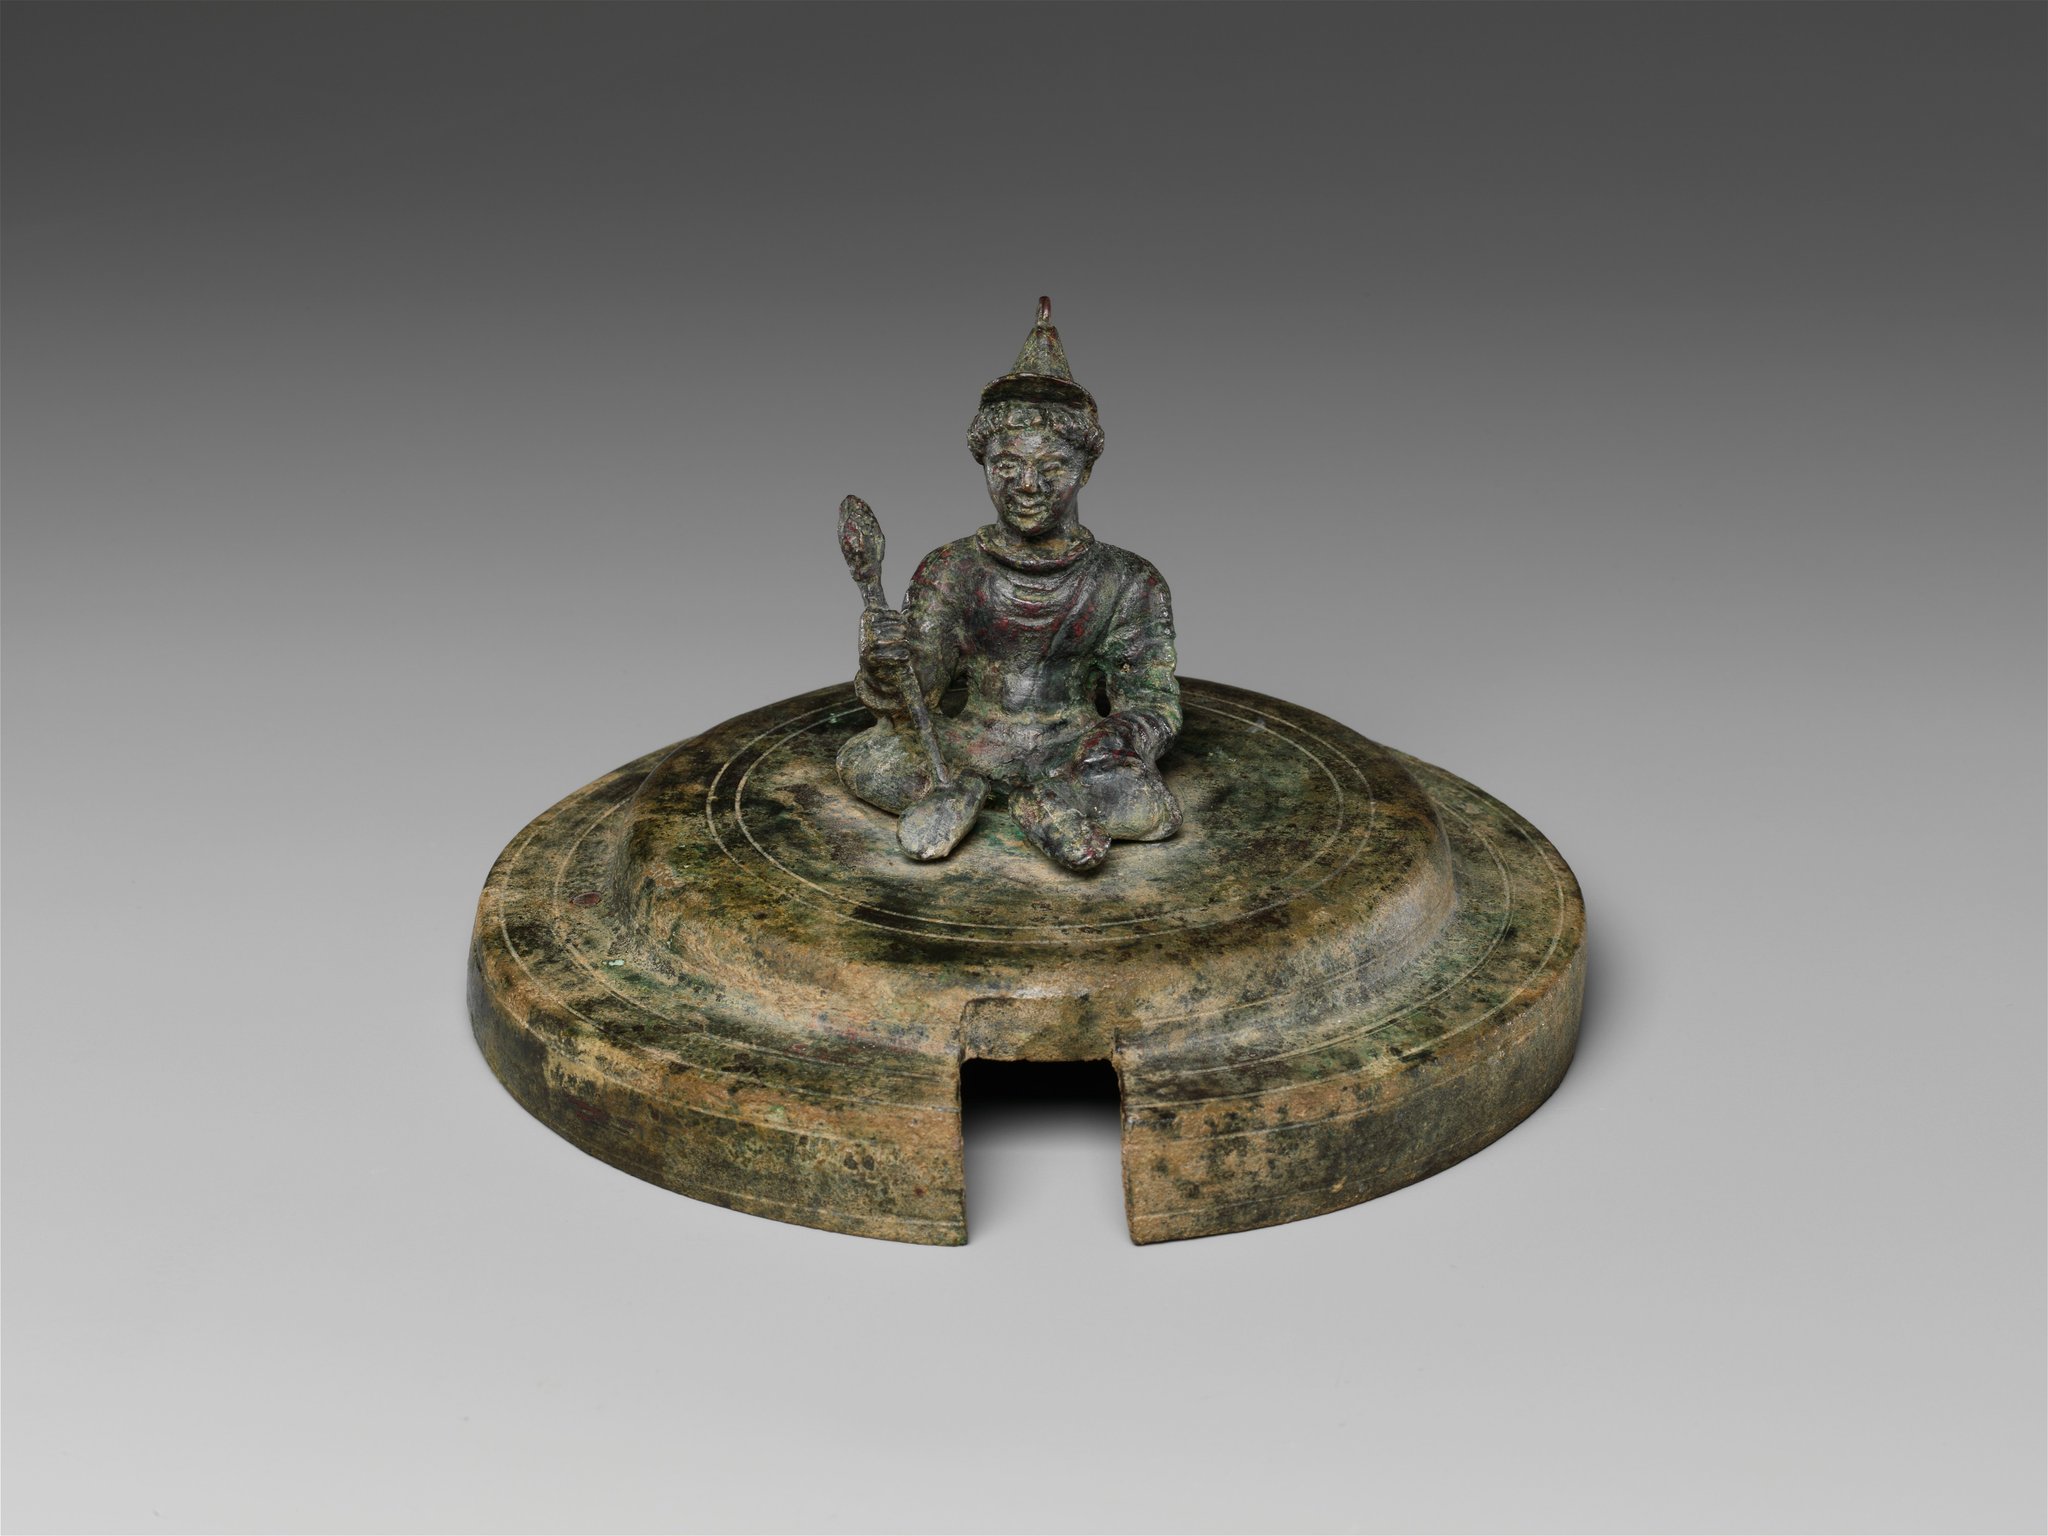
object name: lid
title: Lid with Seated Male Figure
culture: gandhara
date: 1-200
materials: bronze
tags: gandhara,men